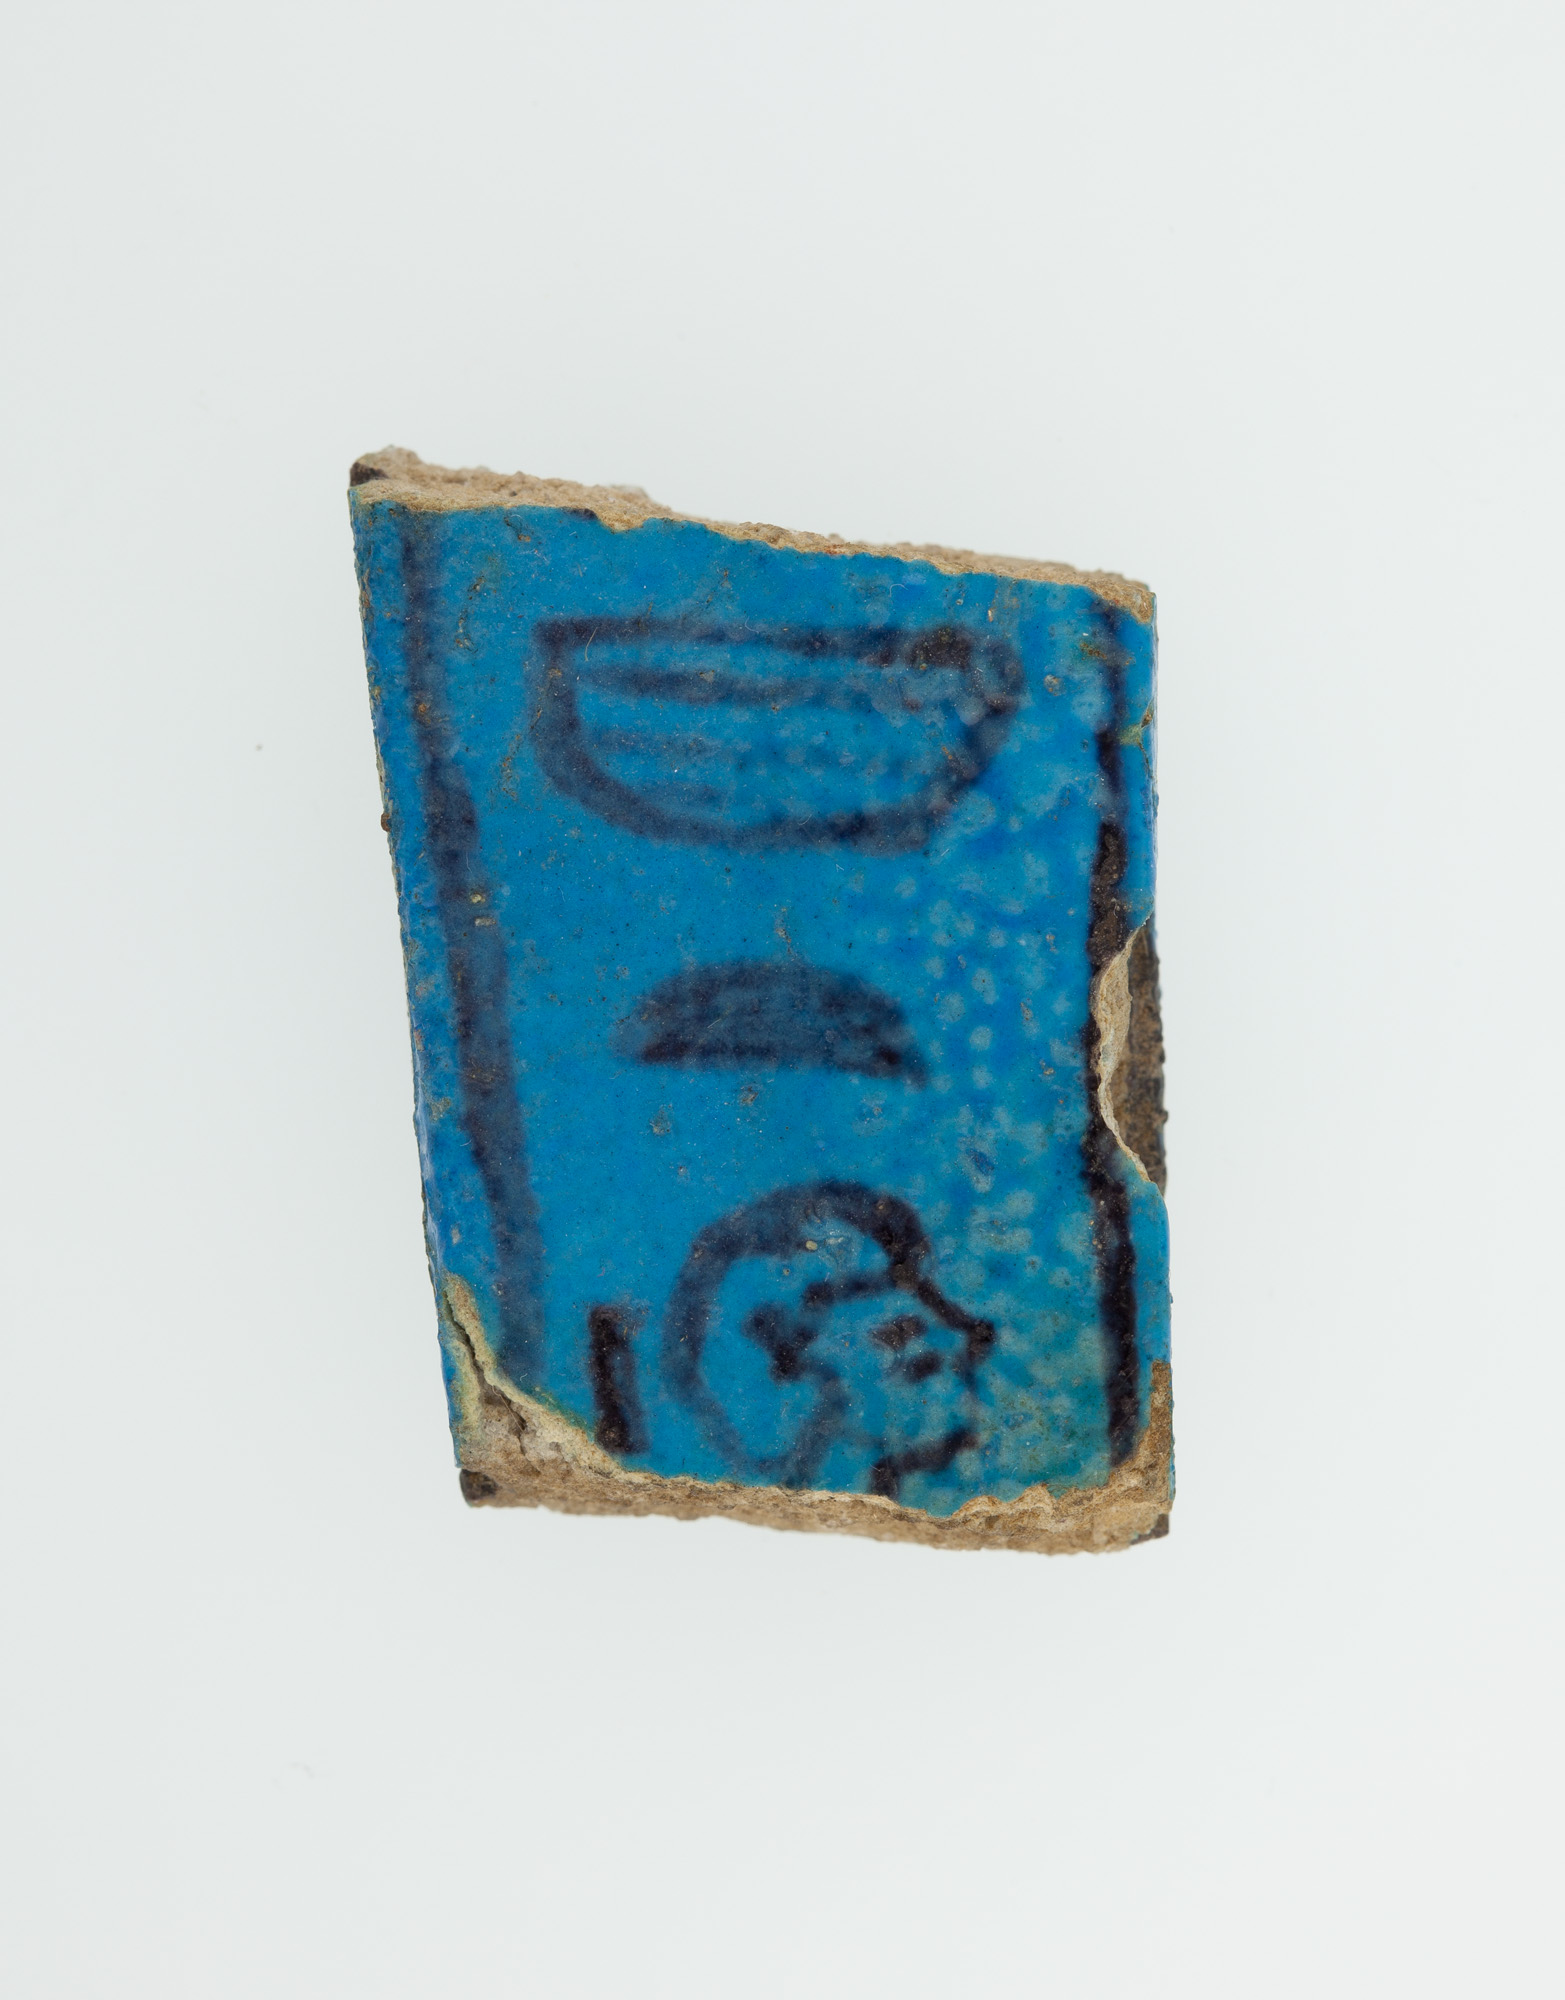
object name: menat fragment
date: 1479-1458 BCE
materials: faience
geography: egypt